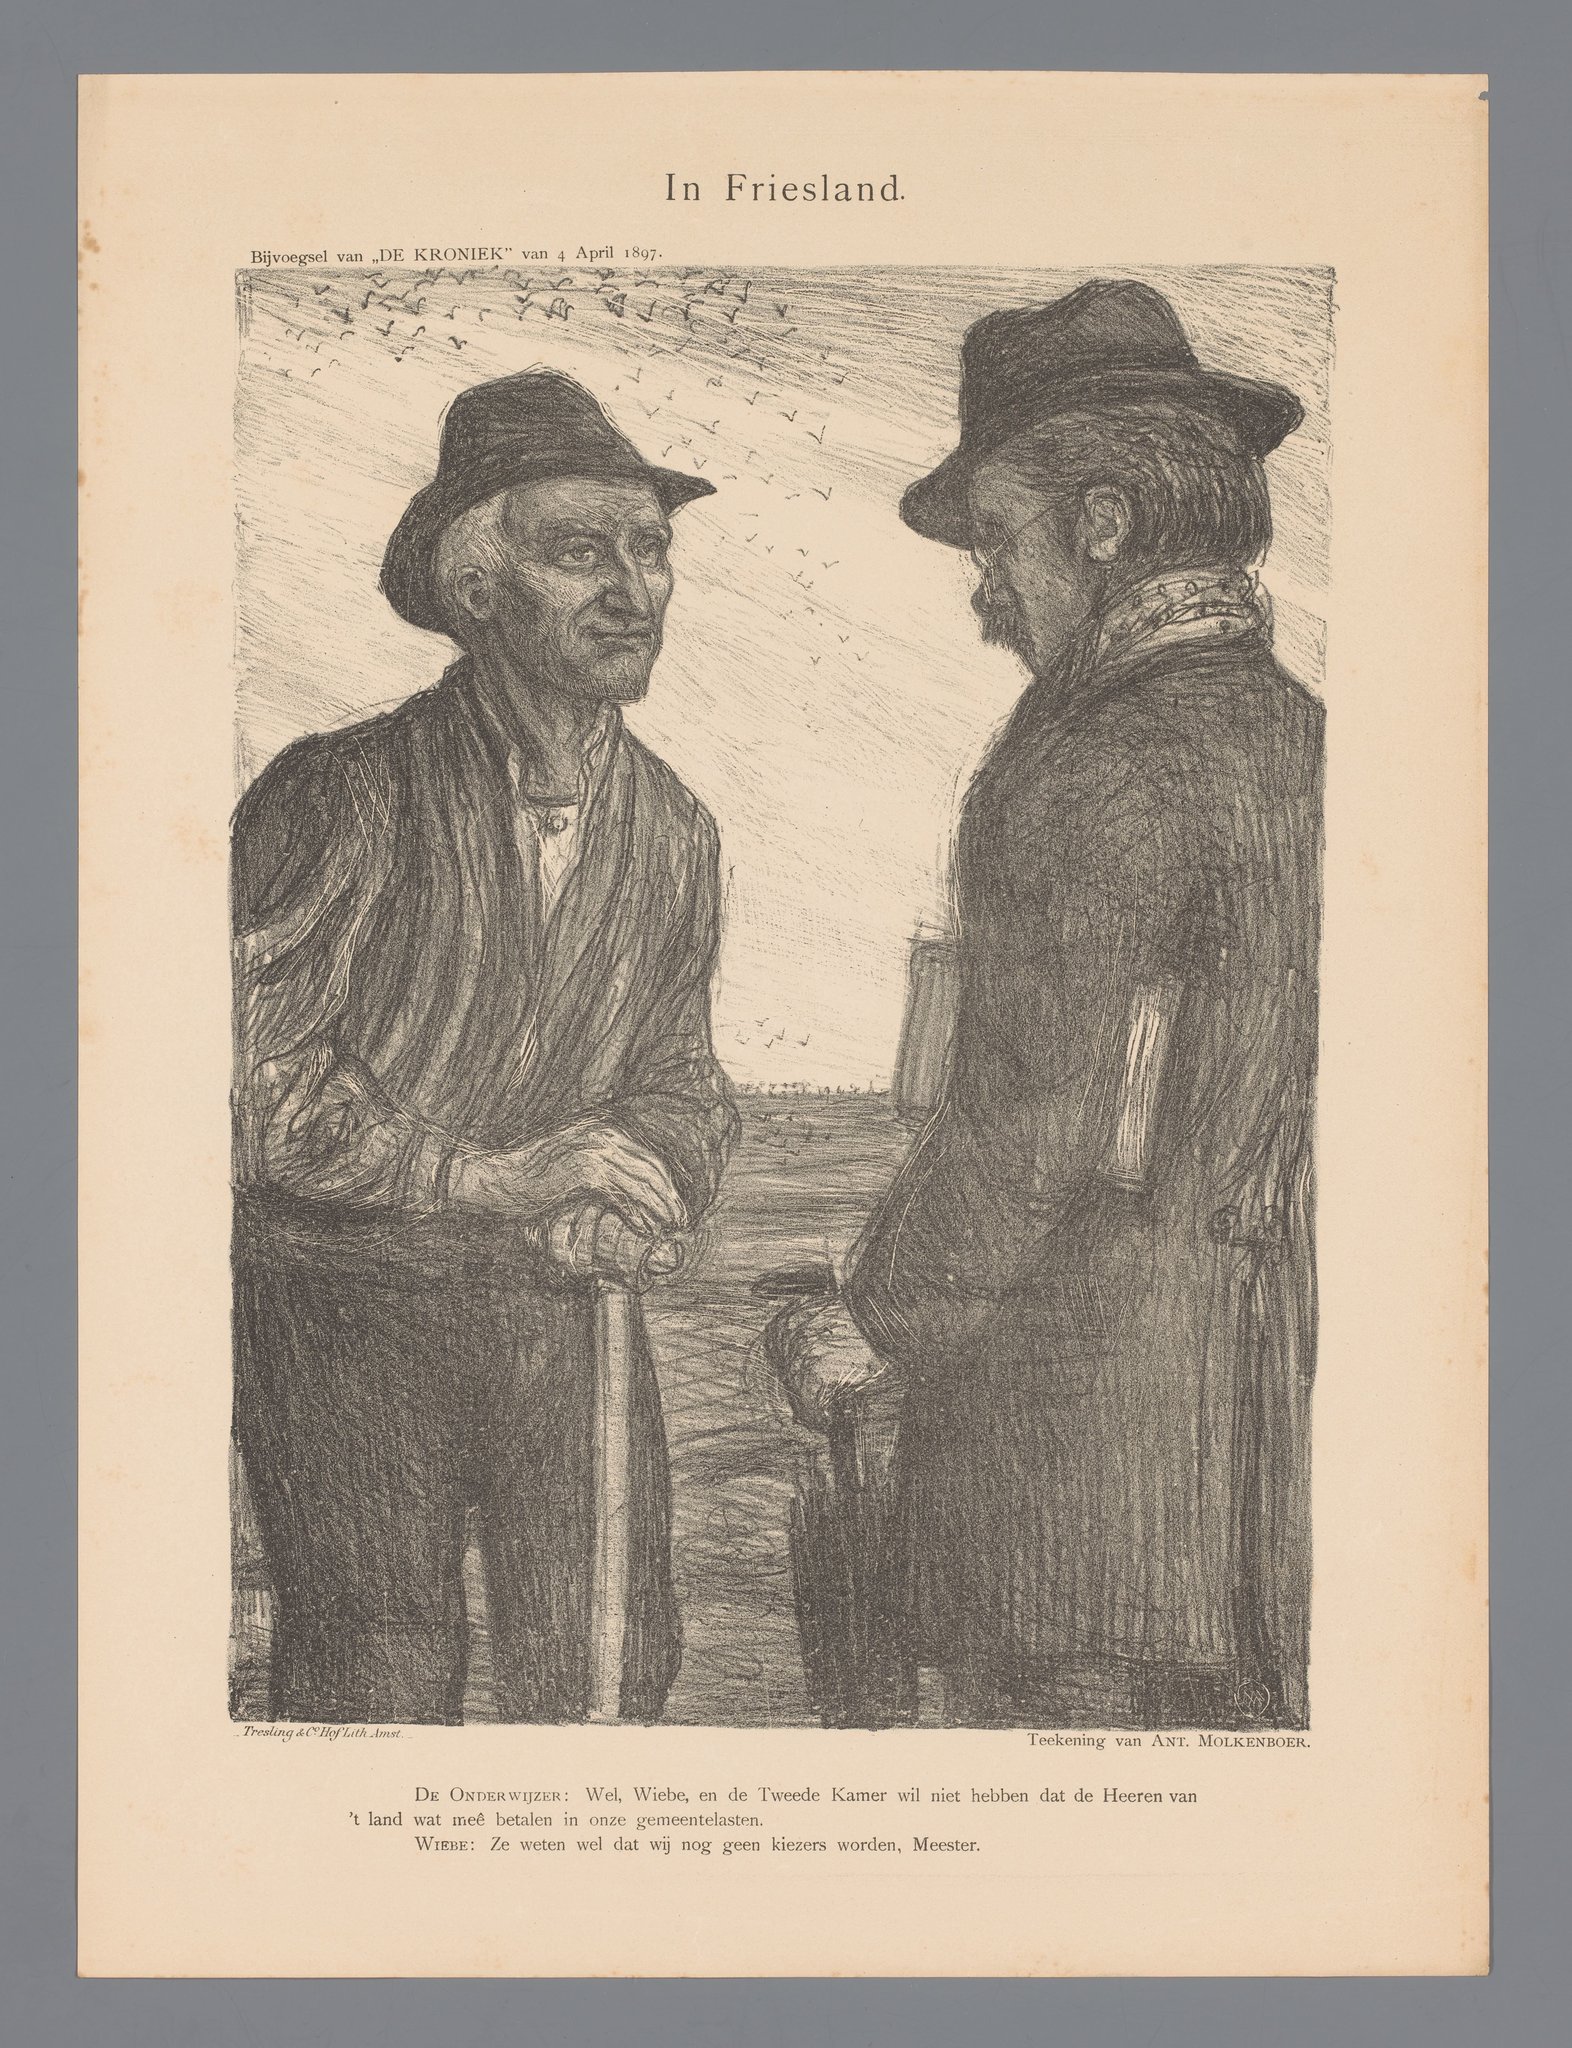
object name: print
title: In Friesland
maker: anton molkenboer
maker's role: print maker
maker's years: 1872-1960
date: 1897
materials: paper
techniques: lithograph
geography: amsterdam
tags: the right to vote, the compulsory vote, farmers, political caricatures and satires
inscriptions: date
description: Prent uit het bijvoegsel van: De Kroniek 3 (1897), 4 april 1897.